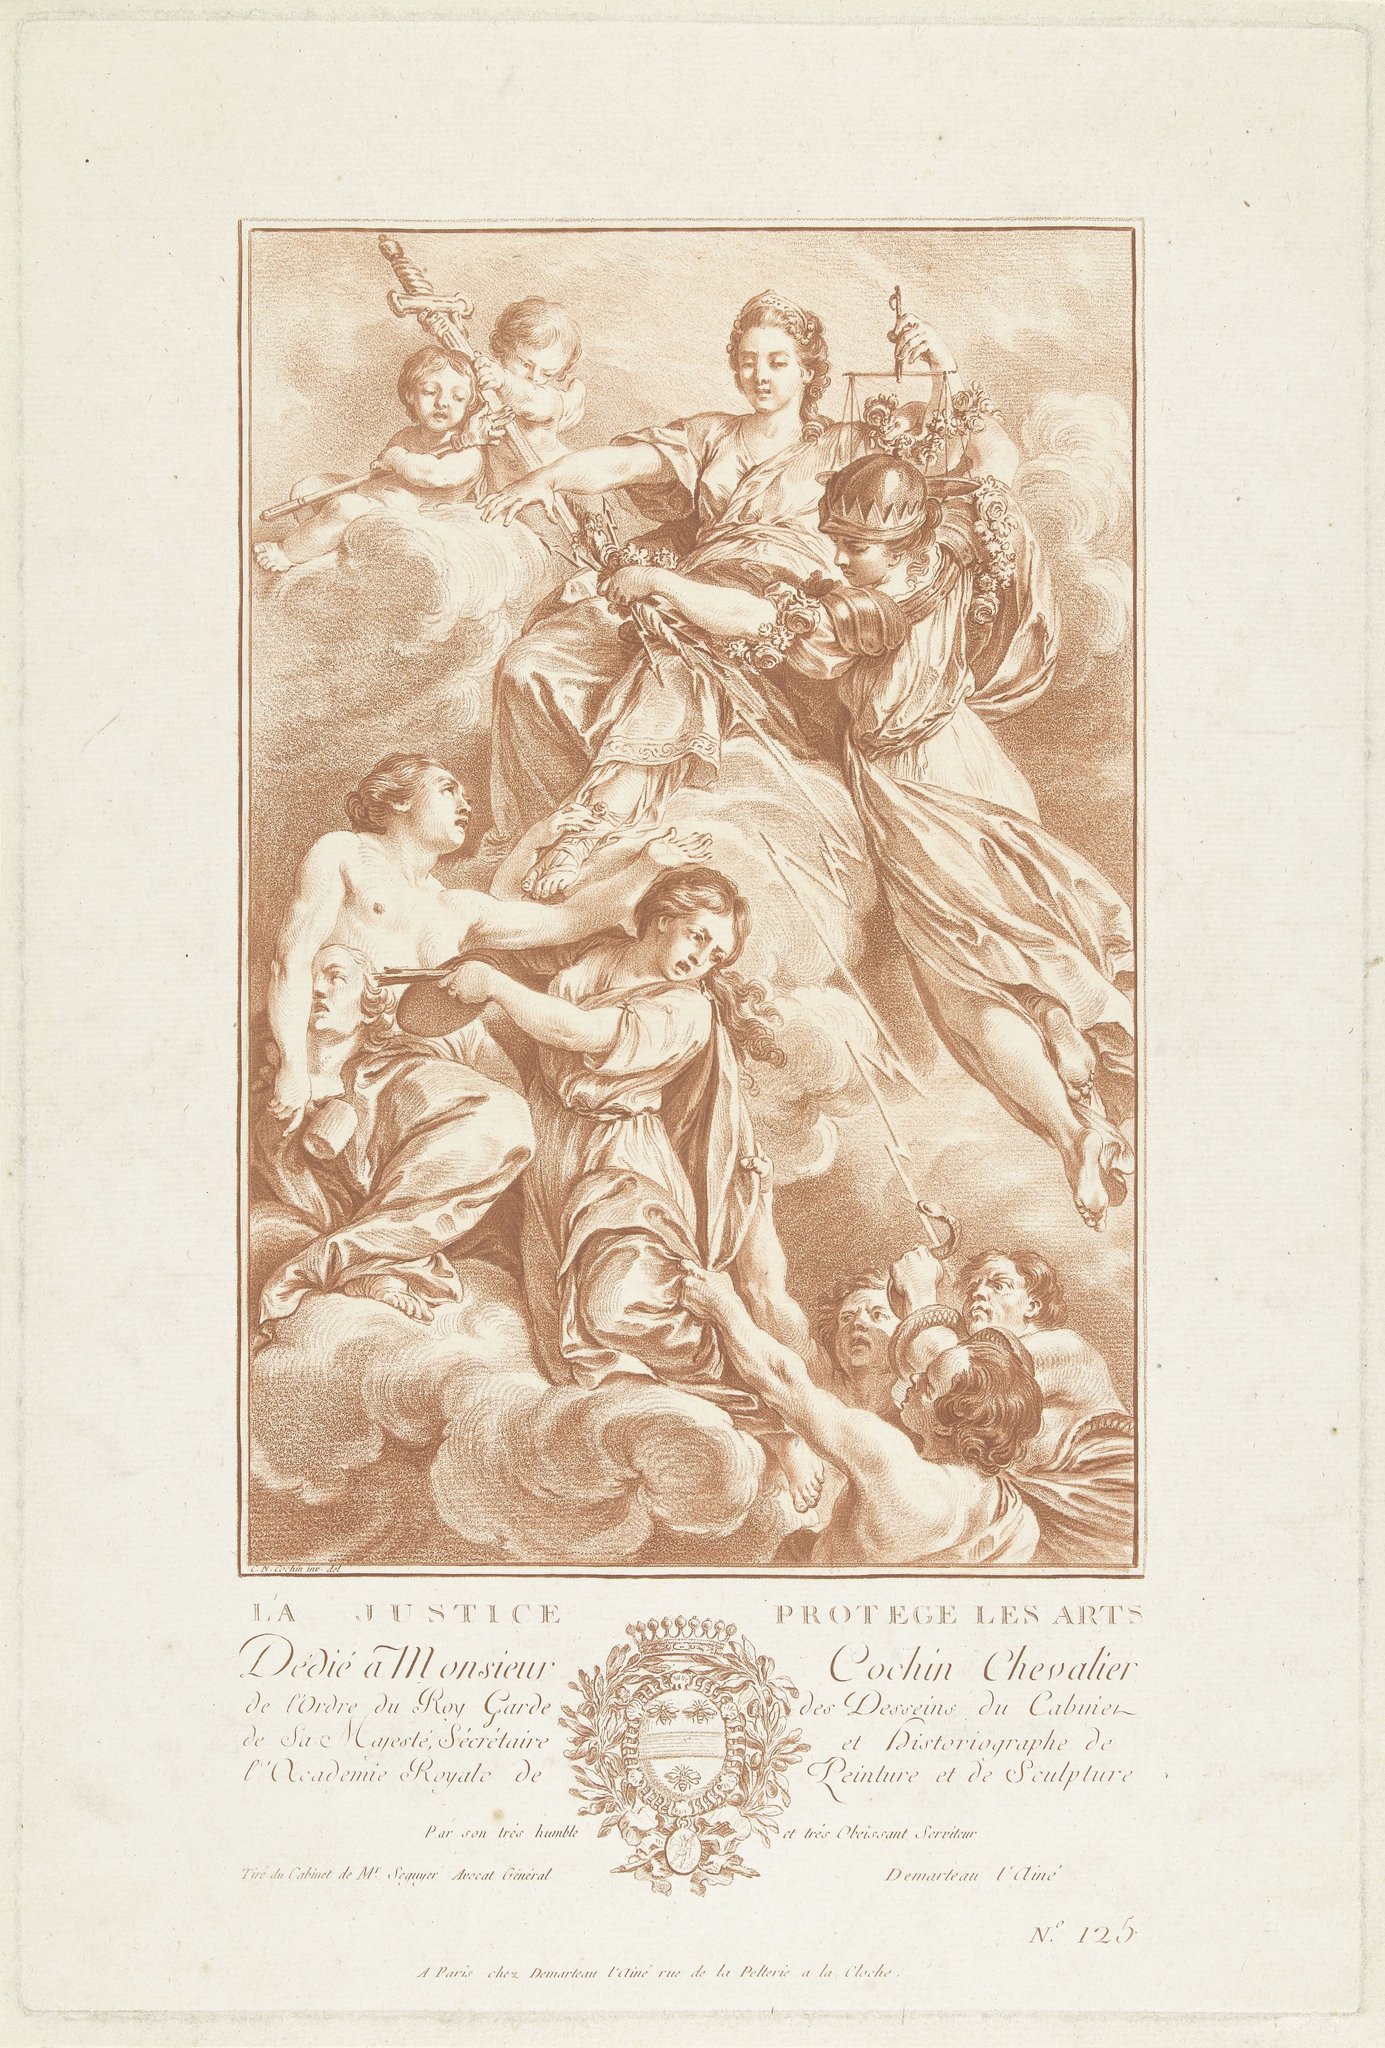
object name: print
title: La Justice protege les arts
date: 1732-1776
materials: paper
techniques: printmaking, etching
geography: paris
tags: minerva as patroness, justitia (justice) as roman personification, symbolic representations, allegories and emblems ~ art; 'arte' (ripa)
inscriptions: collector's mark: Lugt 2228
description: Allegorie met Justitia als beschermster van de kunsten tronend op wolk. Minerva richt bliksemschicht op mannen onder hen die personificatie van schilderkunst trekken aan haar gewaad en haar bedreigen met slang. Vrouwelijke personificatie van beeldhouwkunst maakt smekend gebaar naar de twee godinnen. In ondermarge Franse tekst en gekroond wapenschild met drie bijen.